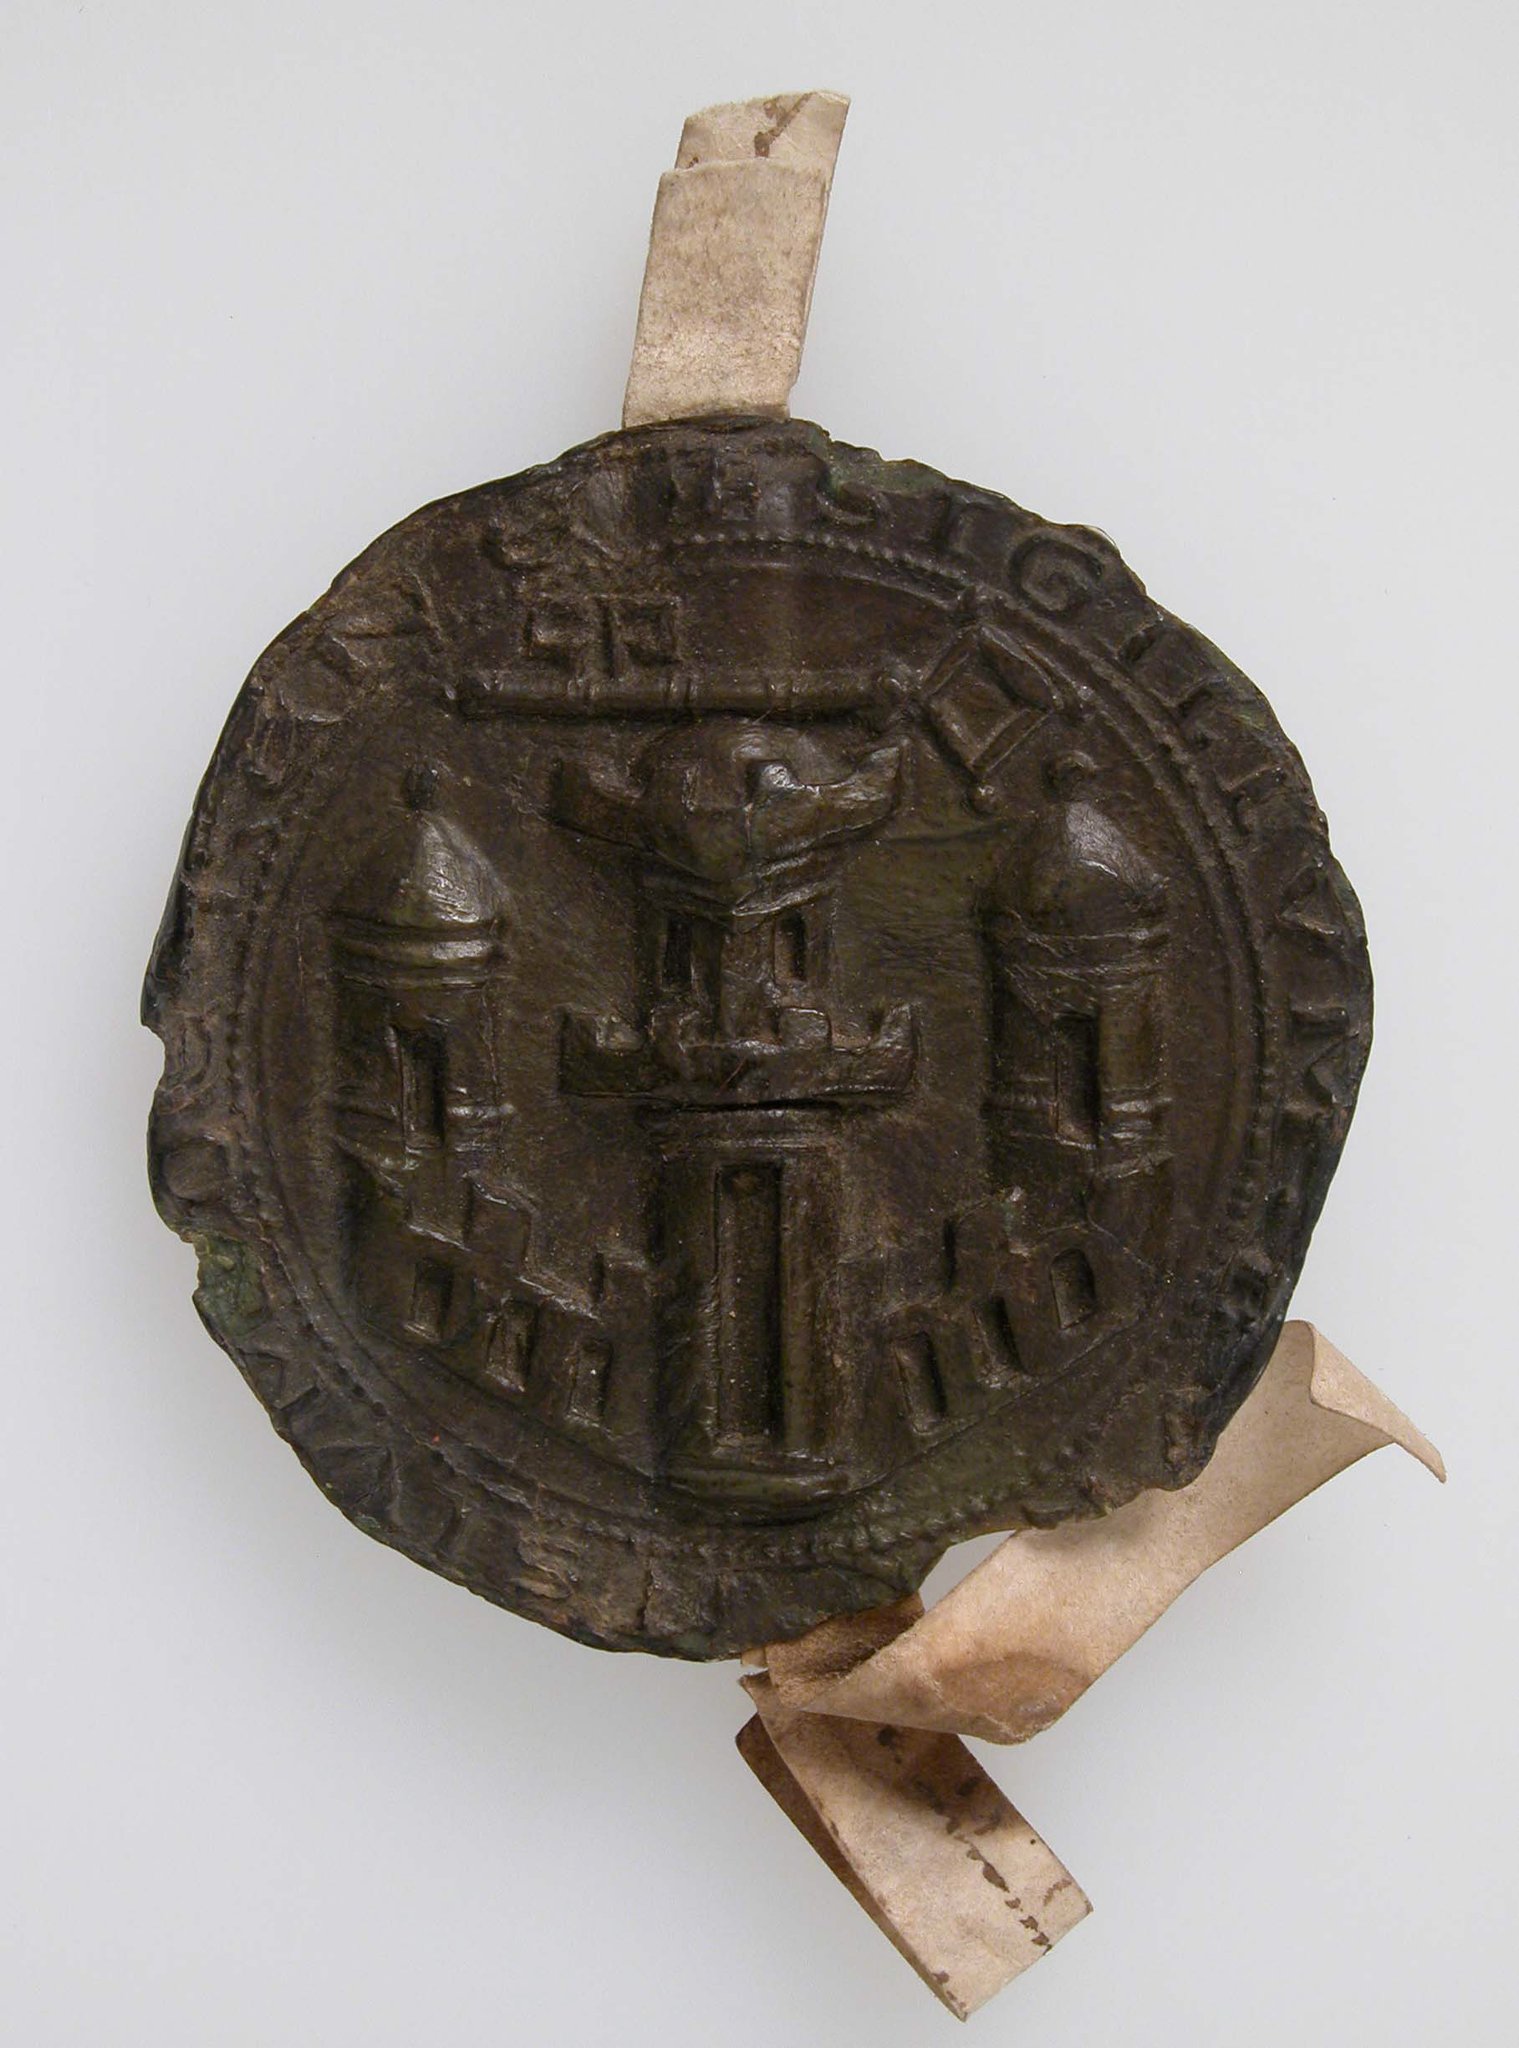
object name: seal impression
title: Seal Impression, City Gates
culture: dutch or south lowlands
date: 1358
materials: wax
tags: gates